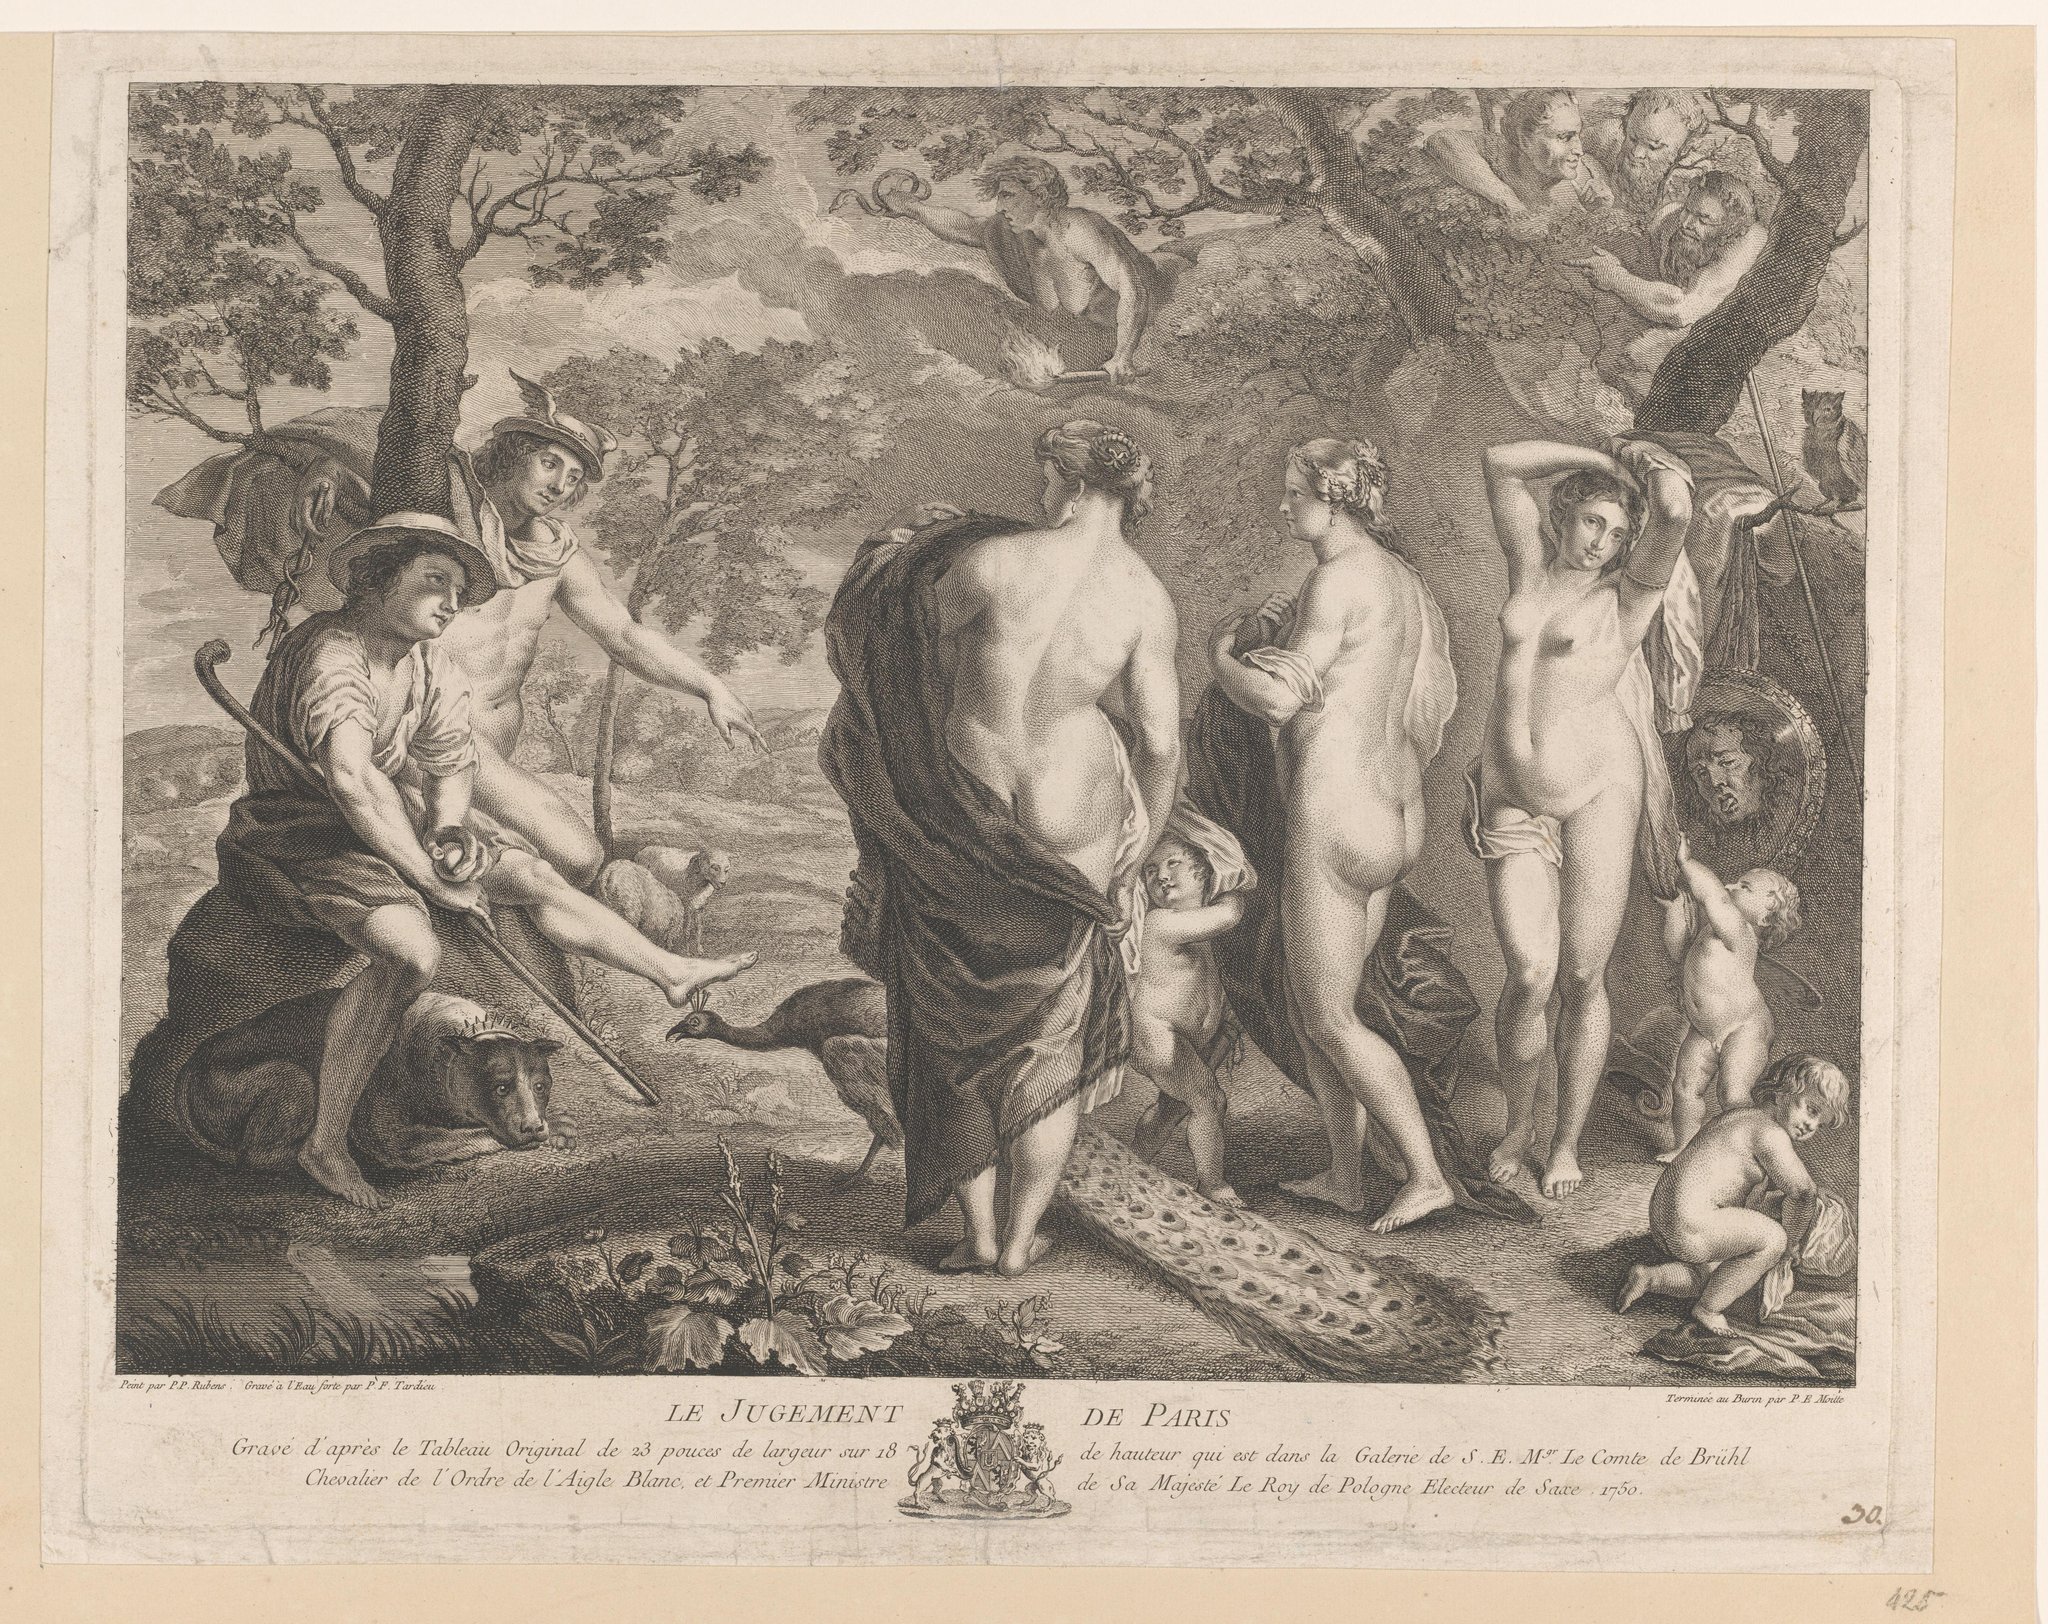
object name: print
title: Etsen naar schilderijen uit de collectie Brühl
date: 1750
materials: paper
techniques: engraving, etching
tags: the judgement of paris (mercury present)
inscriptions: collector's mark: Lugt 240, number: ‘30.’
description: Maakt deel uit van een serie getiteld 'Recueil d'estampes gravées d'après les tableaux de la galerie de S.E.M. le Comte de Brühl', met etsen naar schilderijen uit de collectie Brühl, uitgegeven in Dresden in 1754. Zie British Museum, inv.nr. 1850,0810.431.